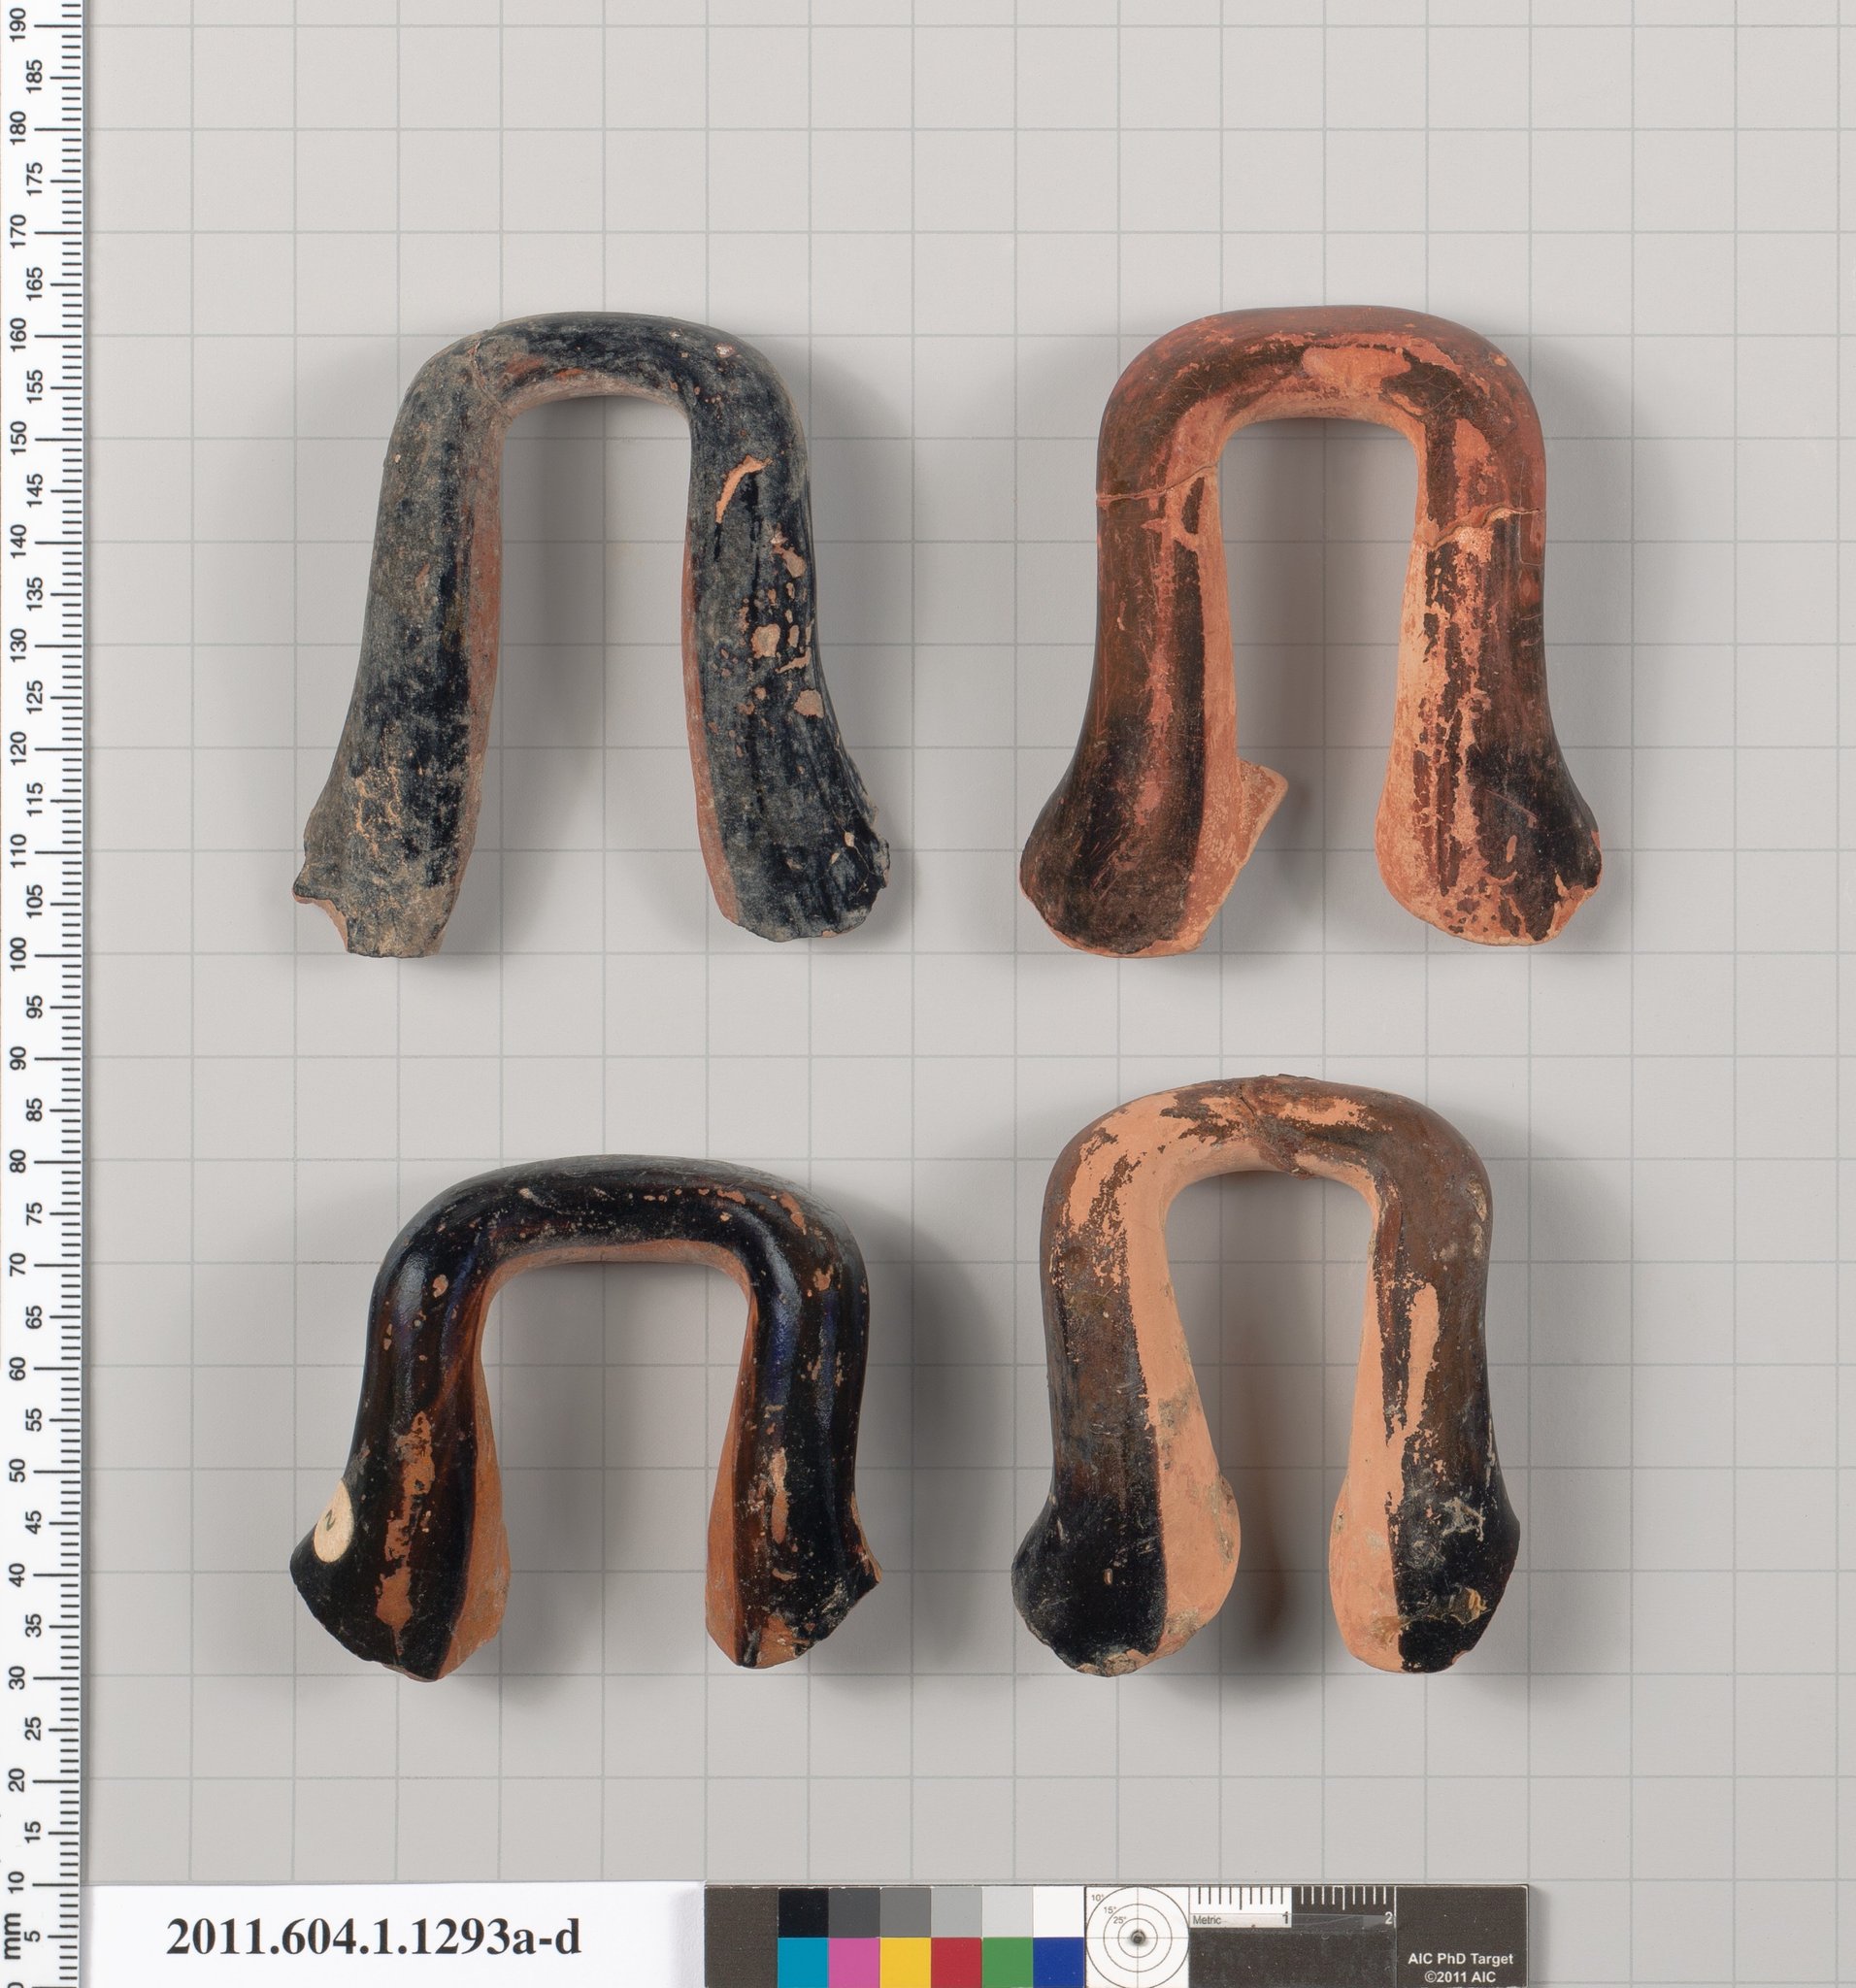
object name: kylix fragment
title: Terracotta fragments of kylikes (drinking cups)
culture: greek, attic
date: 500-401 BCE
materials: terracotta